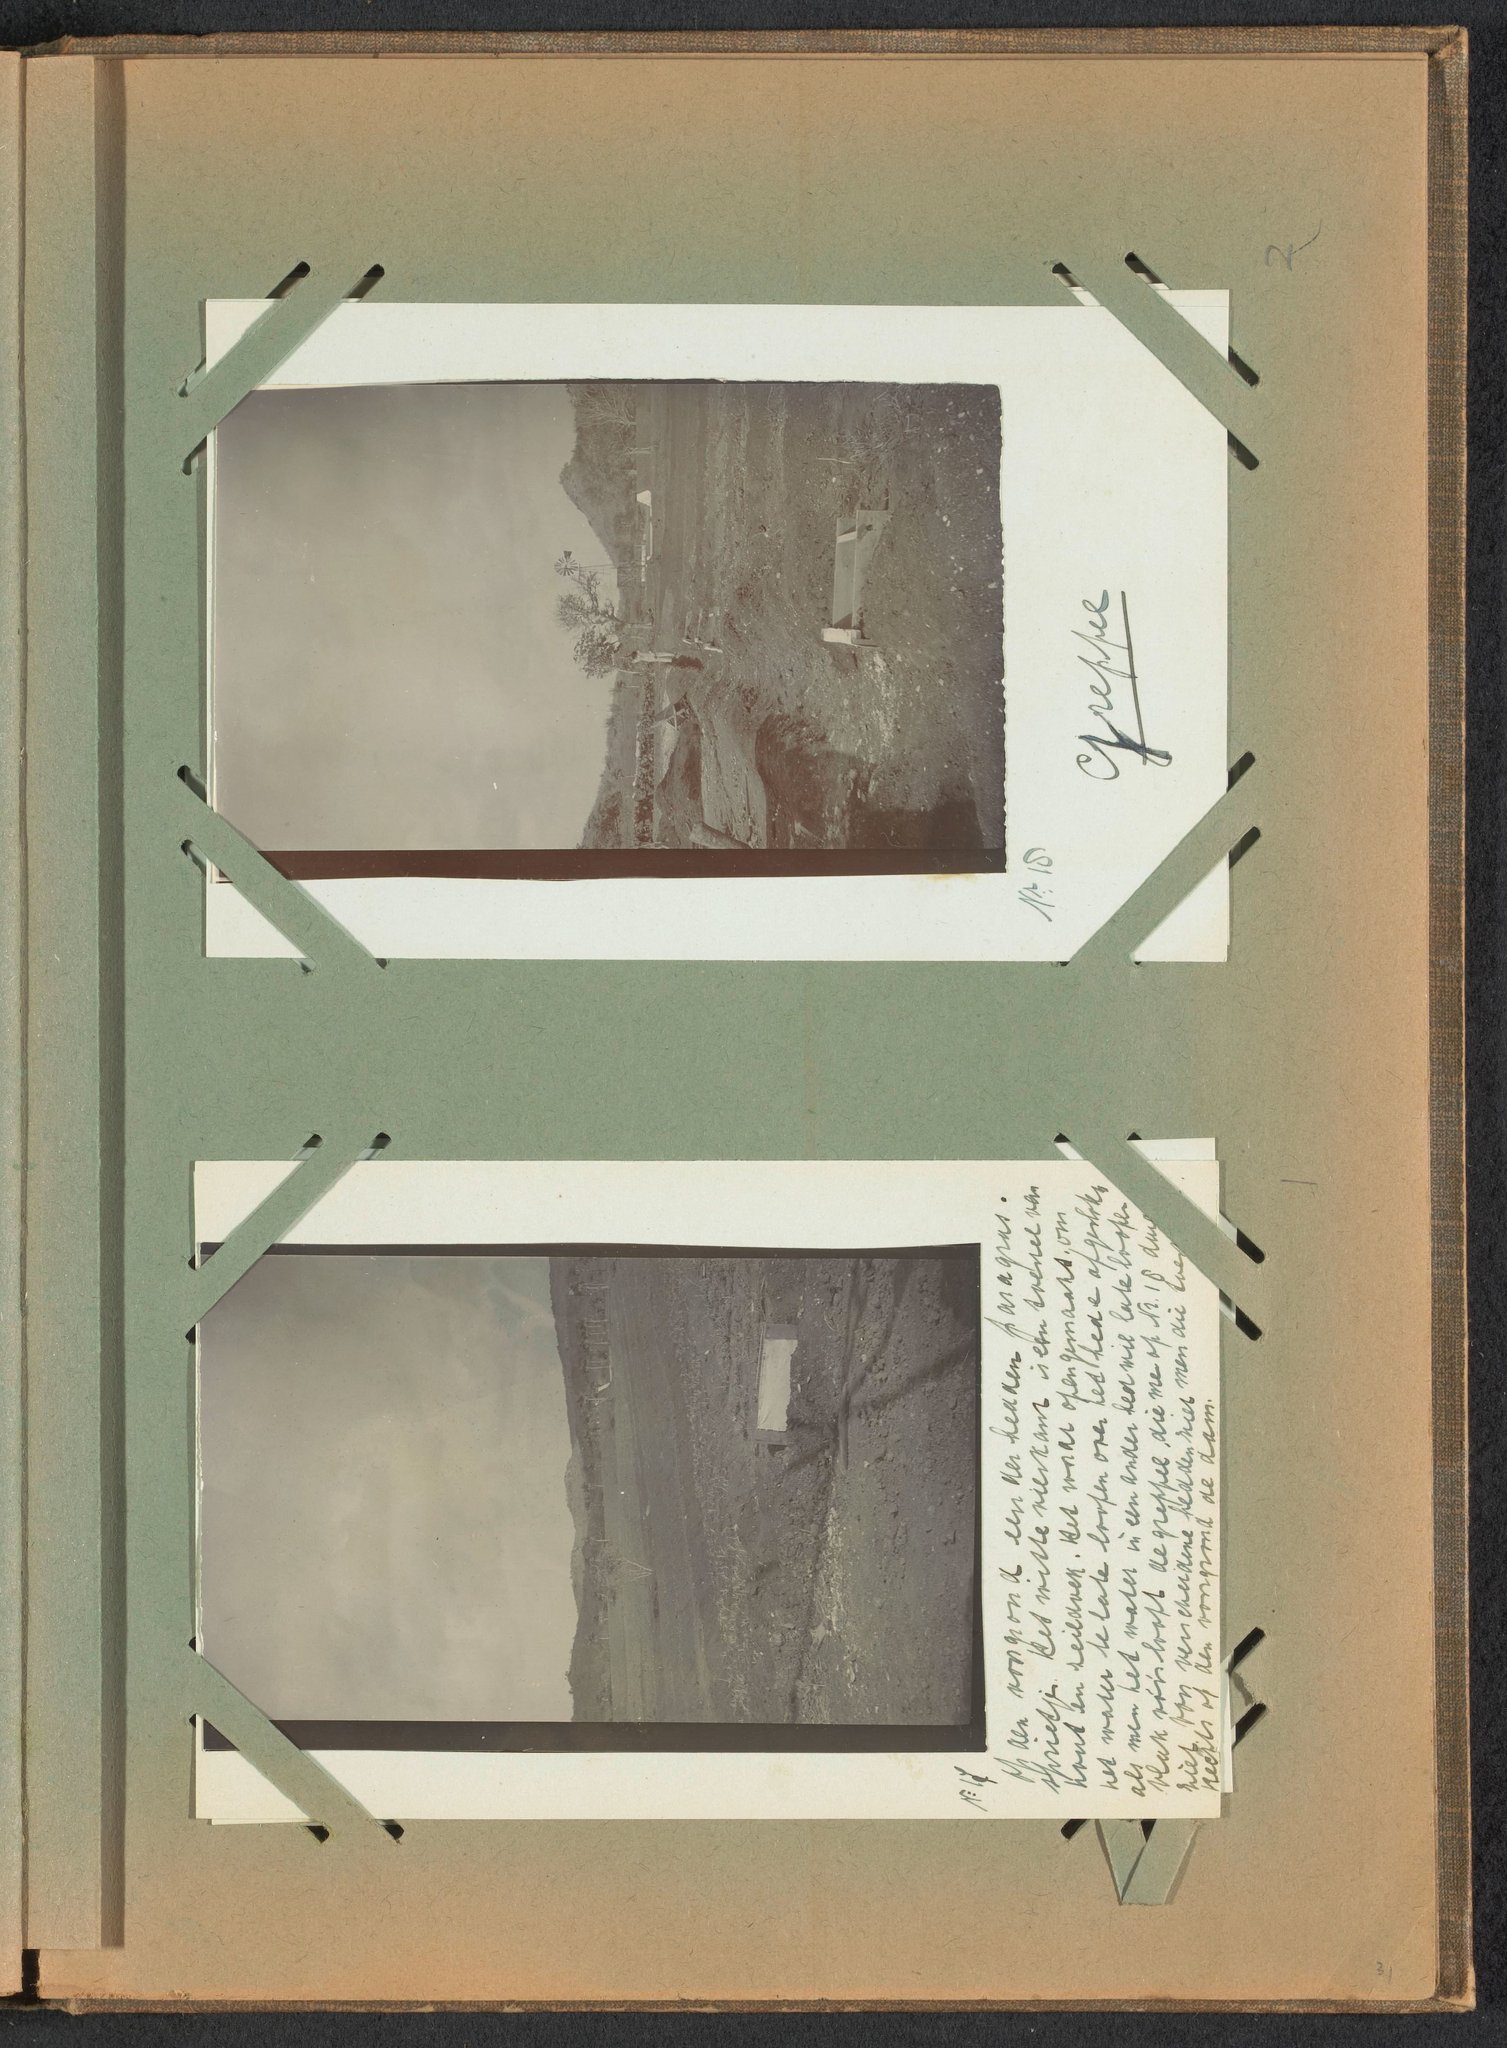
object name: photograph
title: Greppel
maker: Anonymous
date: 1912-1913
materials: paper, photographic support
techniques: gelatin silver print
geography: curacao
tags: plantation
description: Akkers met greppel. Bij Plantage Mount Pleasant op Curaçao. Onderdeel van het fotoalbum uit ca. 1912-1913 met 92 foto's van de plantages Peperpot en Dordrecht in Suriname en Mount Pleasant op Curaçao.